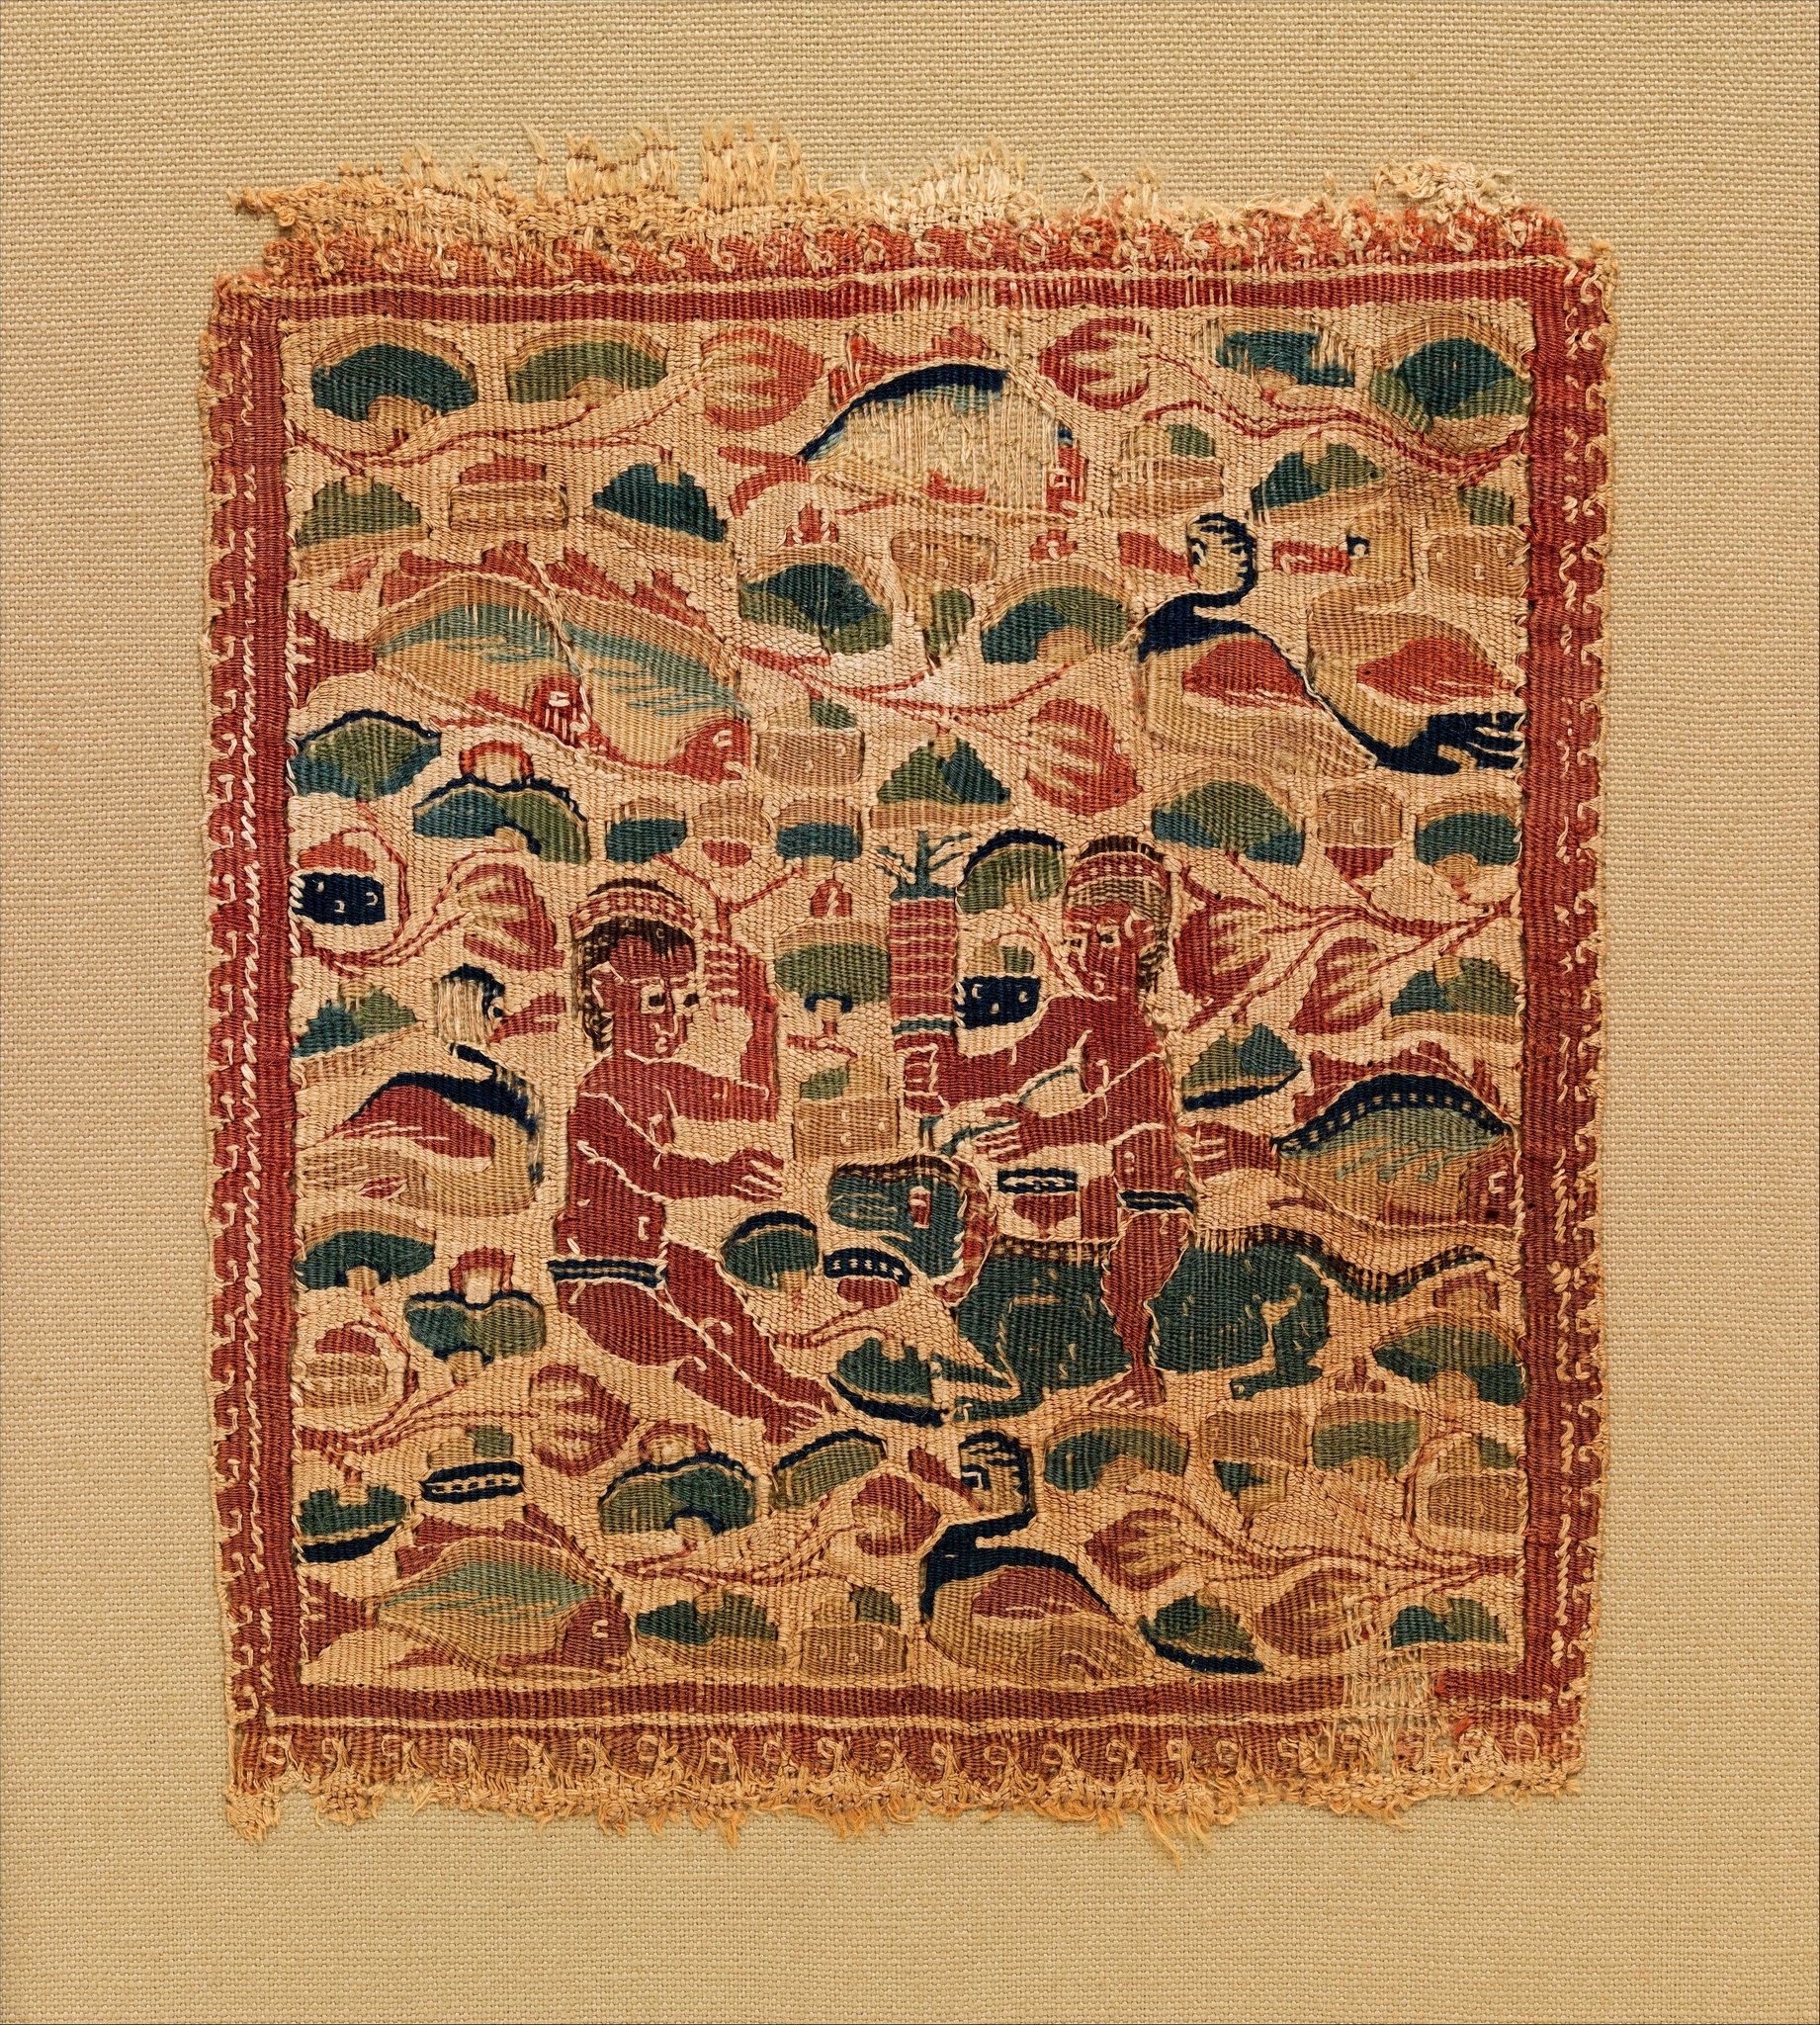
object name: square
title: Square with Putti in a Nilotic Landscape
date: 301-500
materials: linen, wool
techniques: weave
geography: egypt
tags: ducks,putti,fish